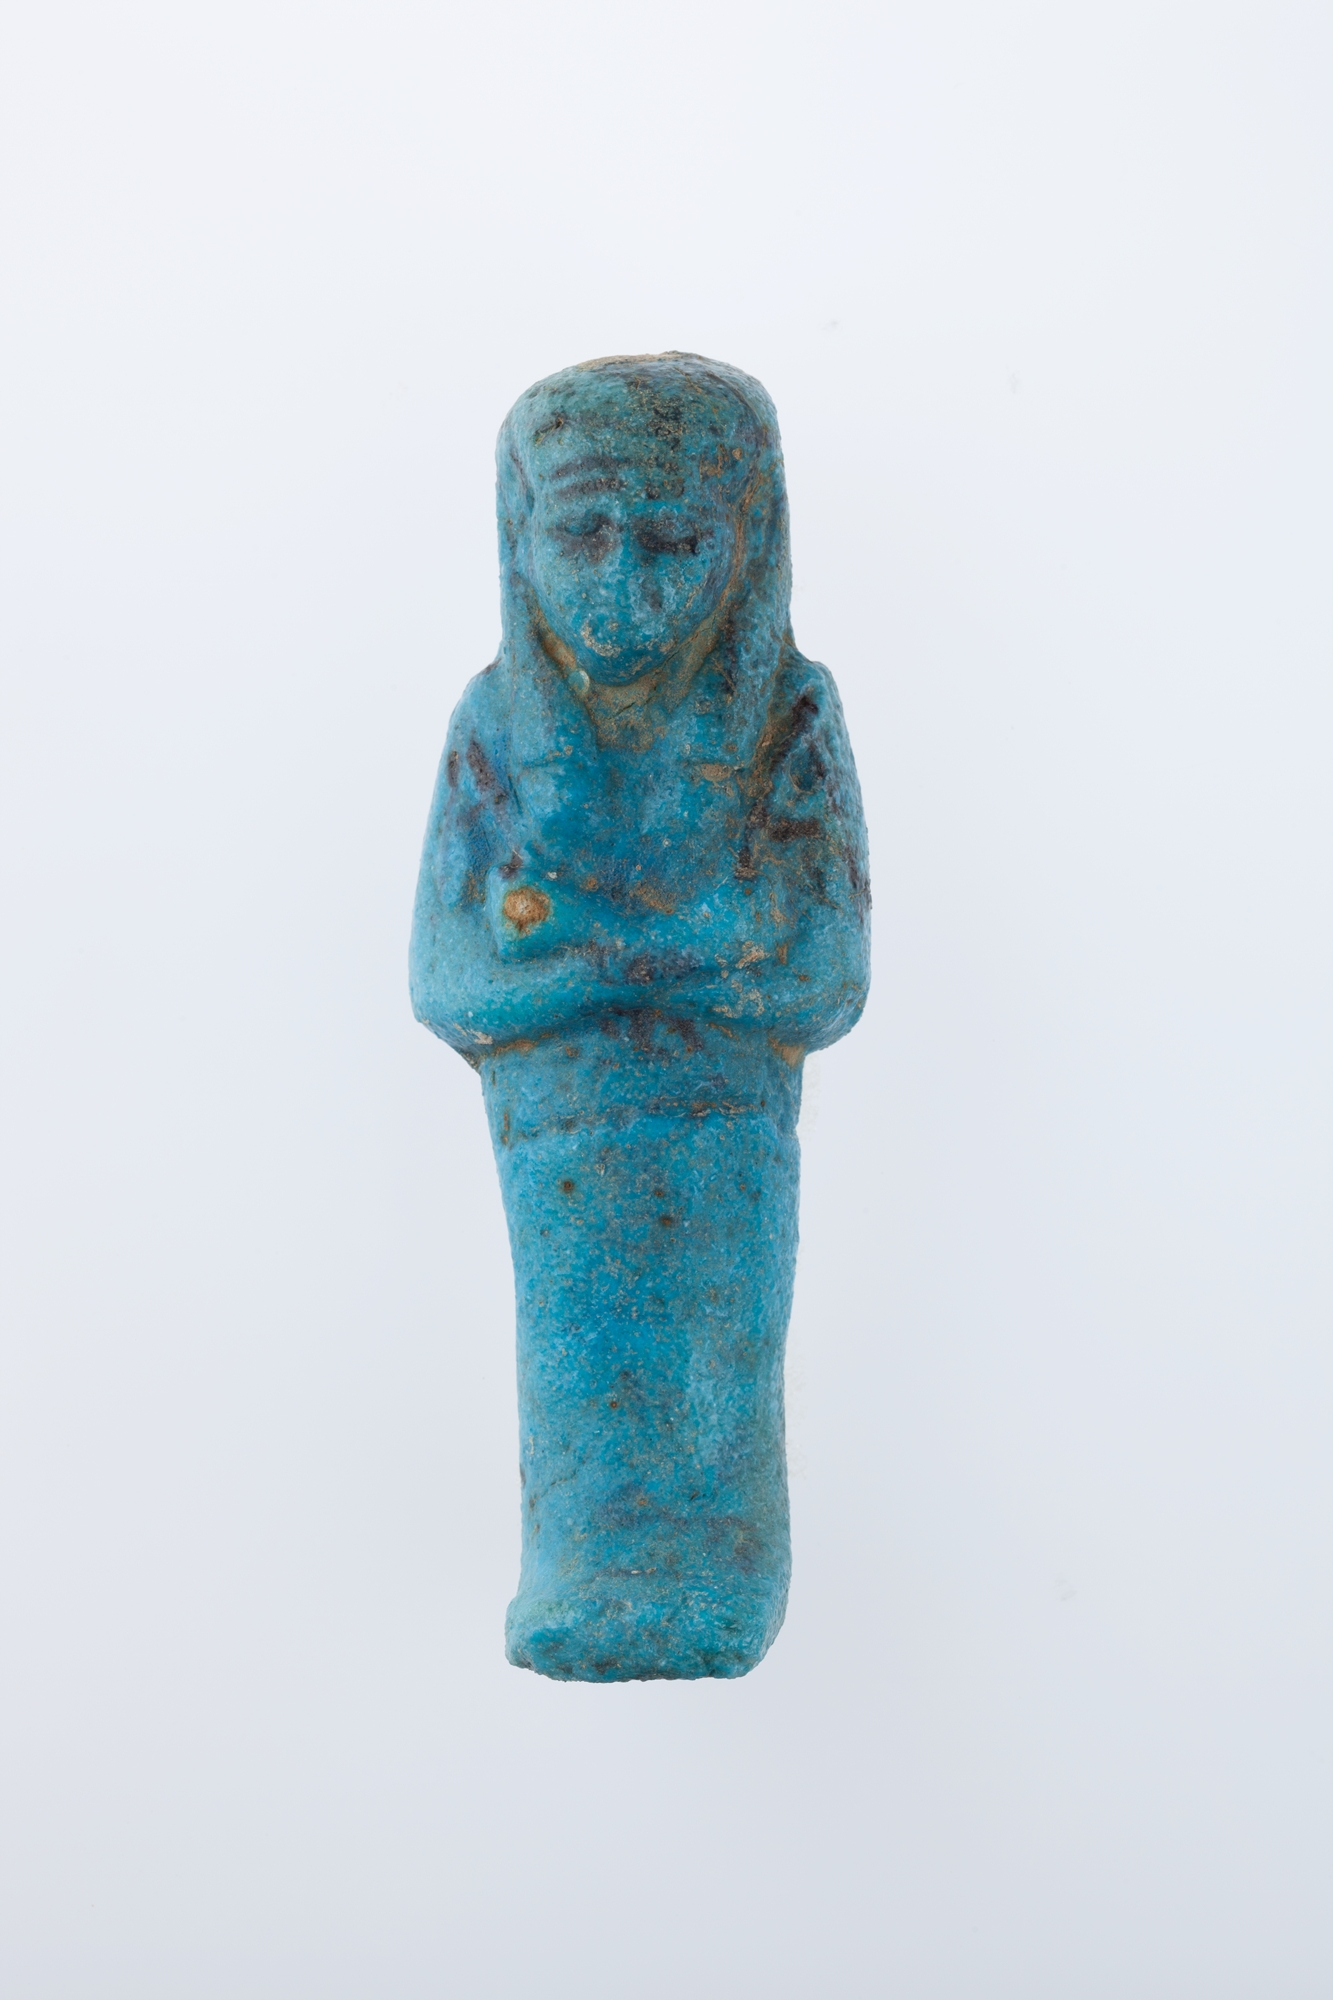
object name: shabti, henettawy c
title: Worker Shabti of Henettawy (C), Daughter of Isetemkheb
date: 990-970 BCE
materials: faience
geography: egypt